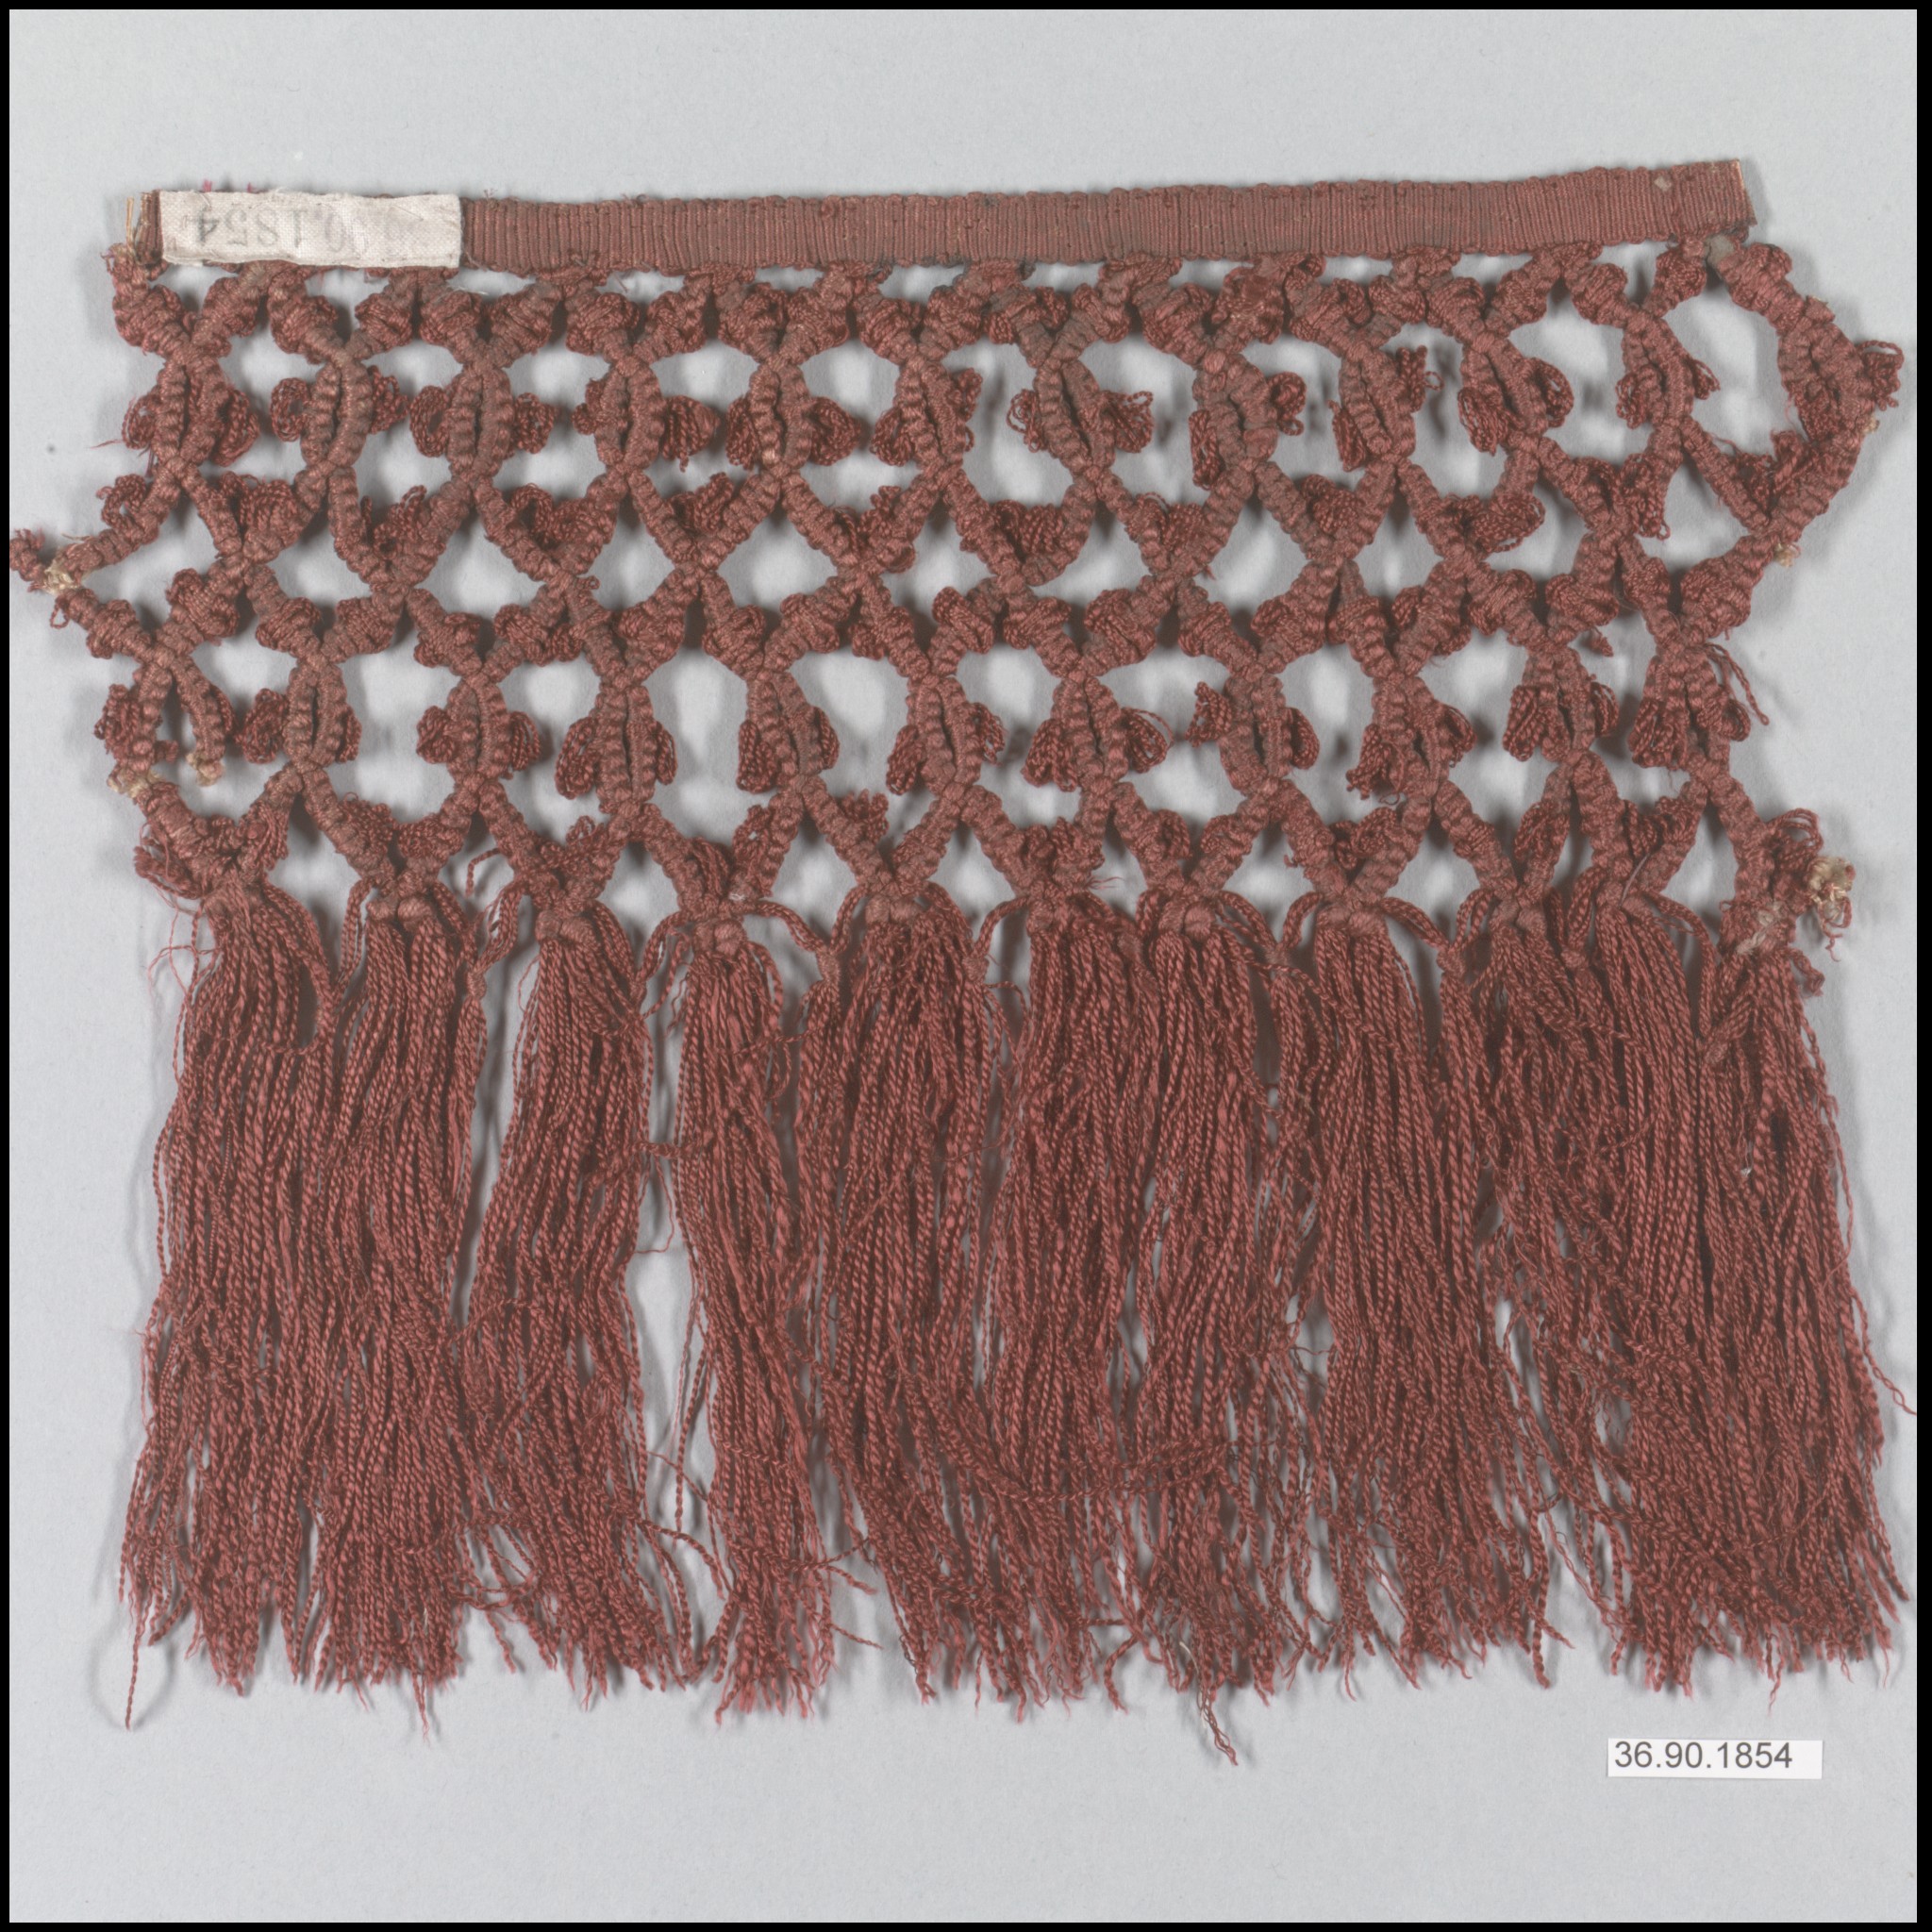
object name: fringe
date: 1801-1833